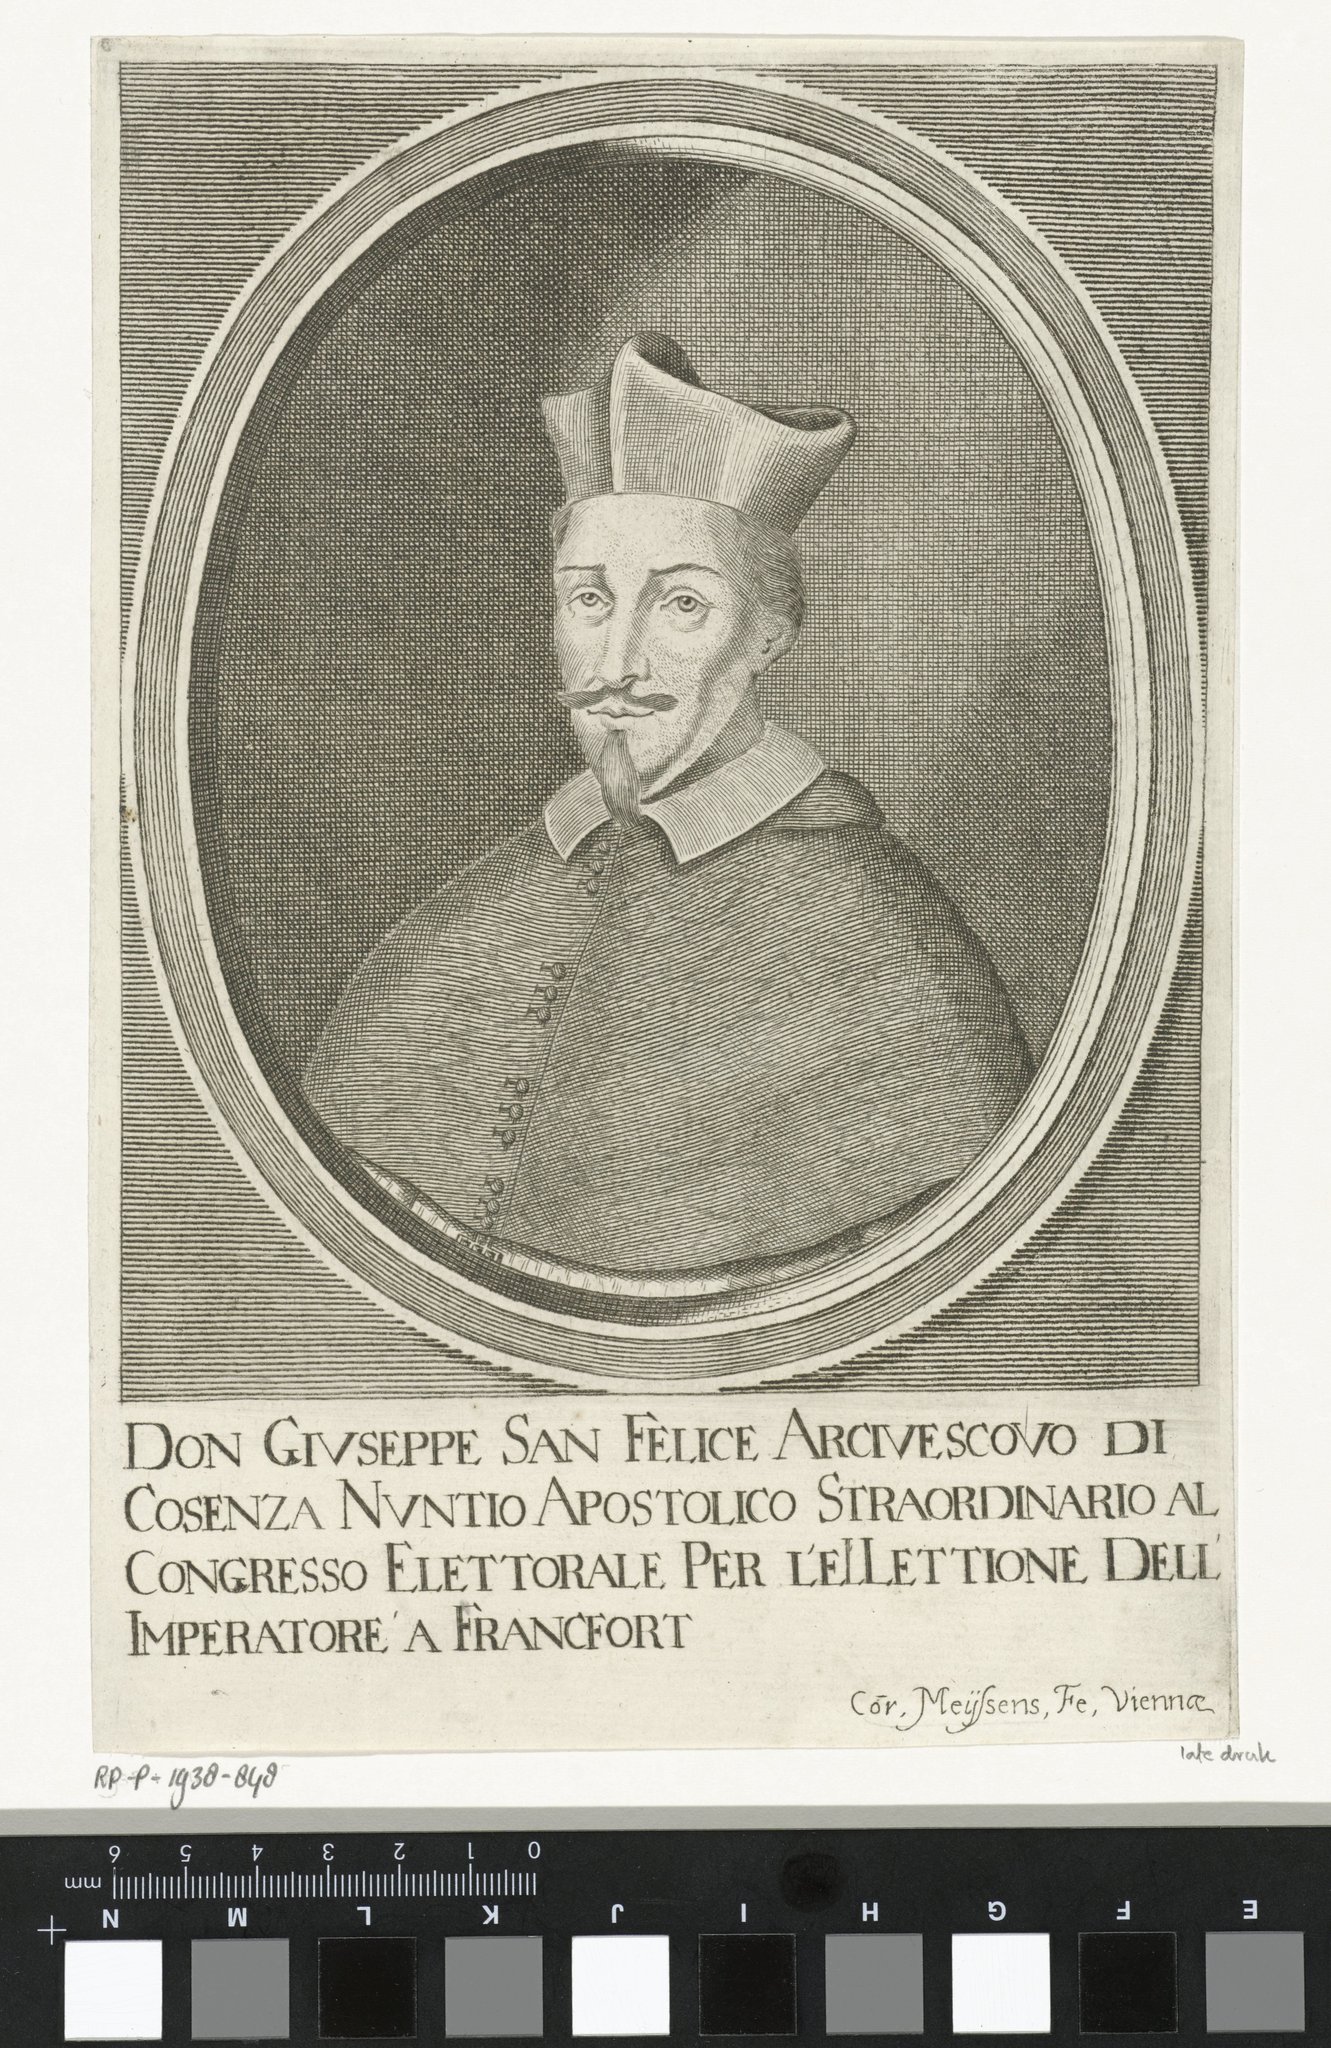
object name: print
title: Portret van Giuseppe Francisco Maria Sanfelice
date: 1670-1674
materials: paper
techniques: engraving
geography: vienna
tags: naples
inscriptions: collector's mark: Lugt 2228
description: Prent mogelijk gebruikt in: Gualdo Priorato, Galeazzo. Historia di Leopoldo Cesare, (...). 3 dln. Wenen, Giovanni Battista Hacque, 1670-1674.